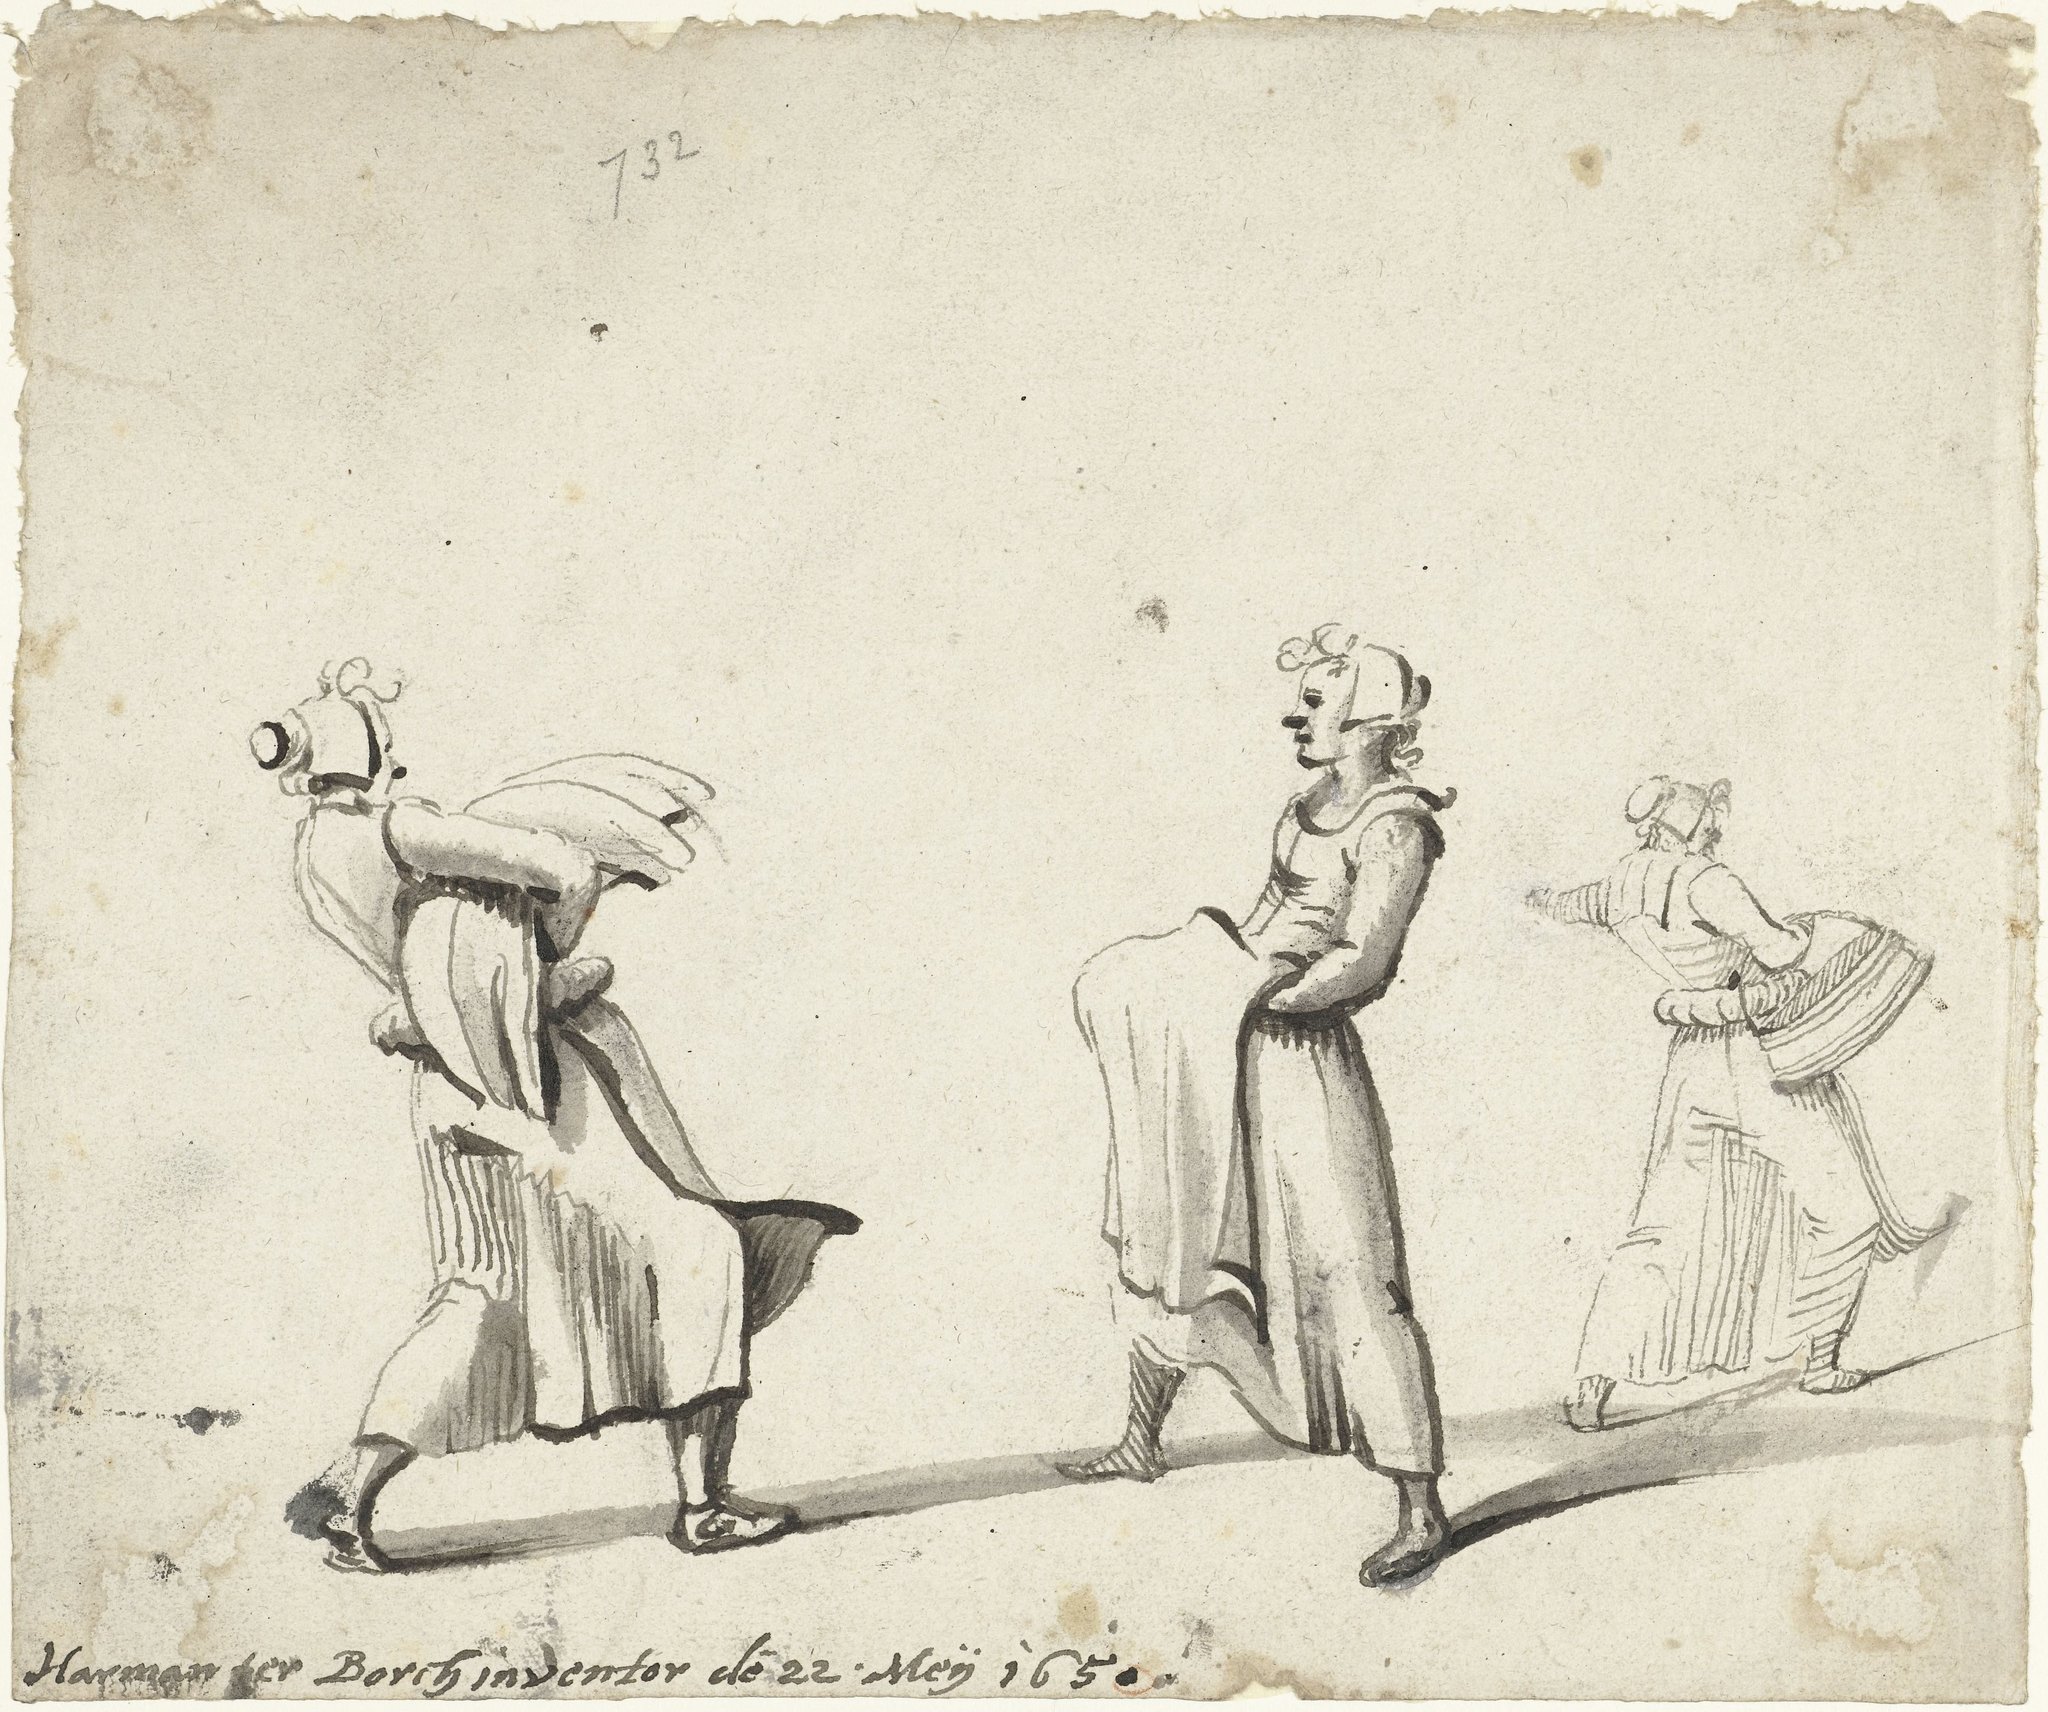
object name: drawing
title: Studieblad met drie lopende vrouwen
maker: harmen ter borch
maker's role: draughtsman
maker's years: 1638-1677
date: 1650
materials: chalk, ink, paper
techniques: brush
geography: zwolle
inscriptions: annotation: ‘Harman ter Borch inventor den 22.Meij 1650’